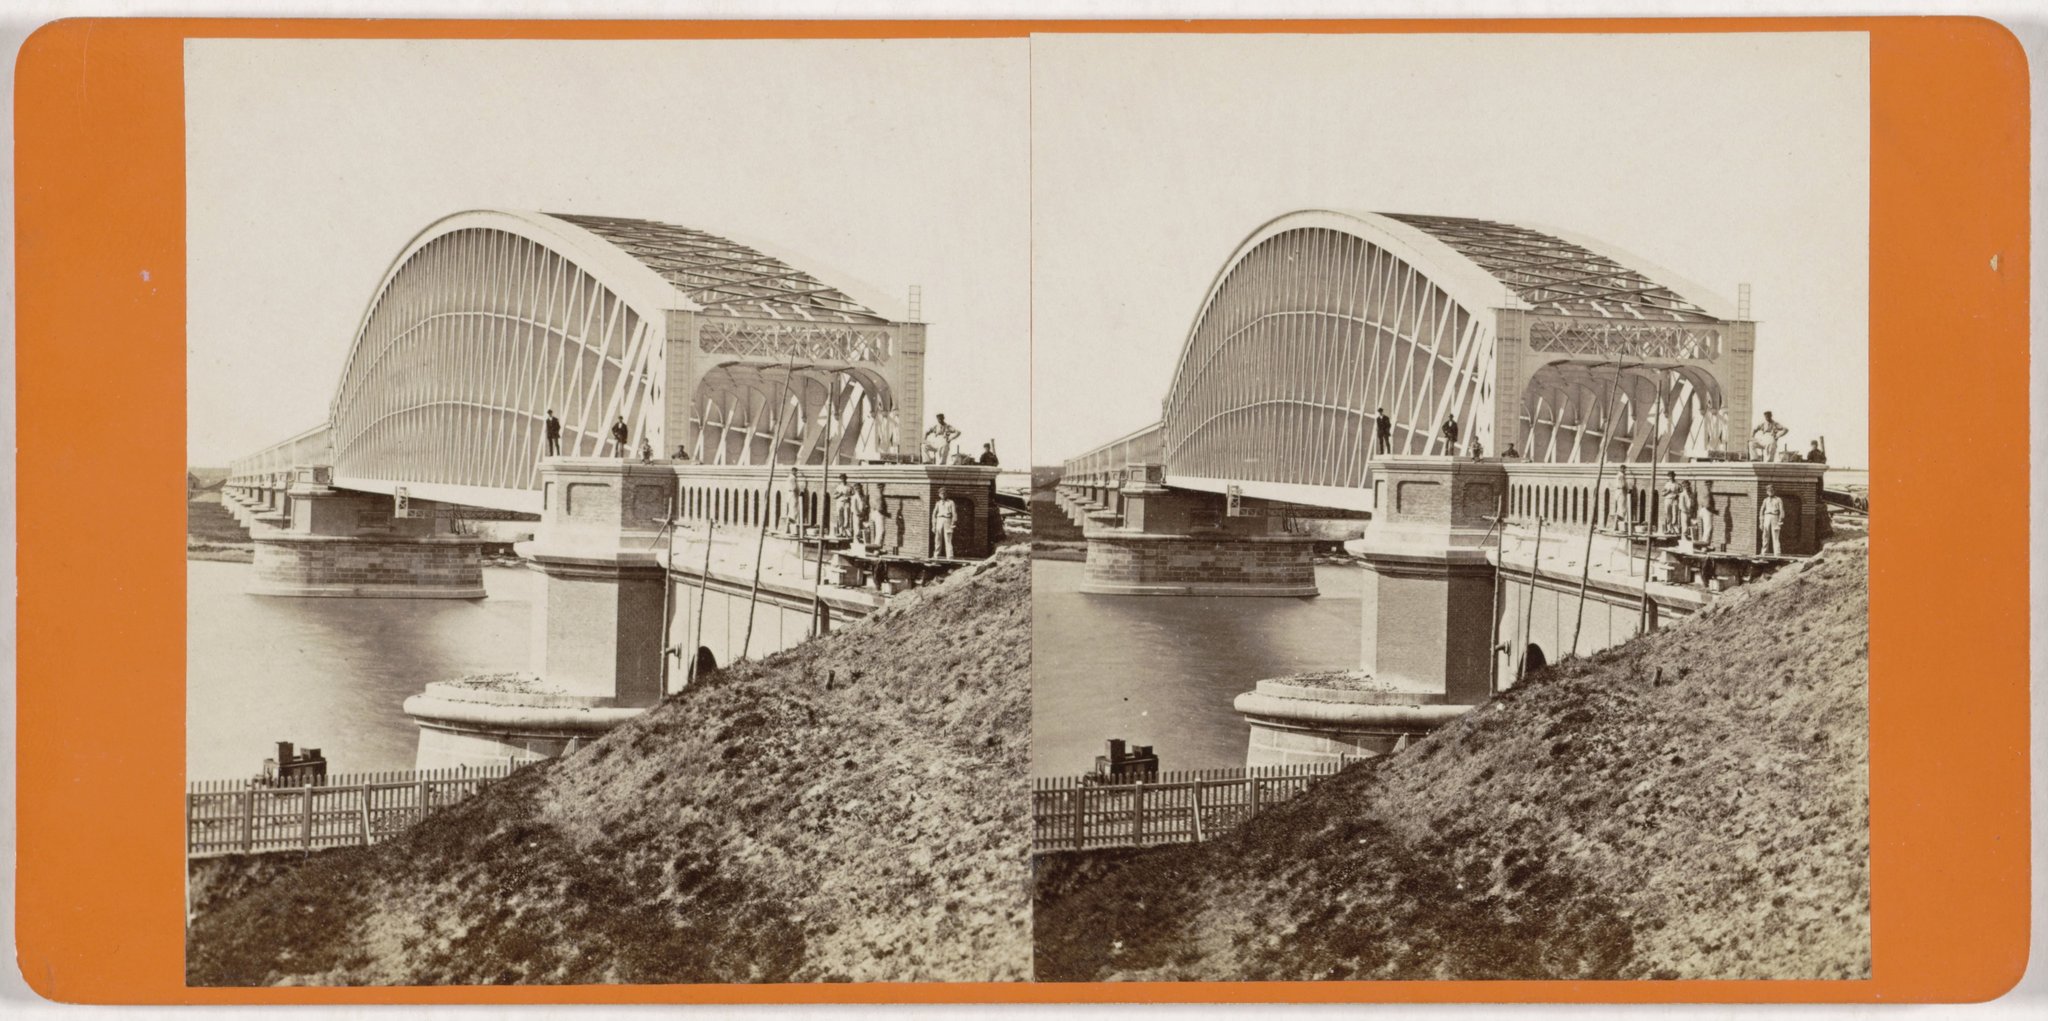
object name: stereograph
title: Brug te Kuilenburg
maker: pieter oosterhuis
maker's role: draughtsman, print maker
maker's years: 1816-1885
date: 1868-1885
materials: cardboard, paper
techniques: albumen print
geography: culemborg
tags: bridge in village across river, canal, etc. - ii - ideal landscapes